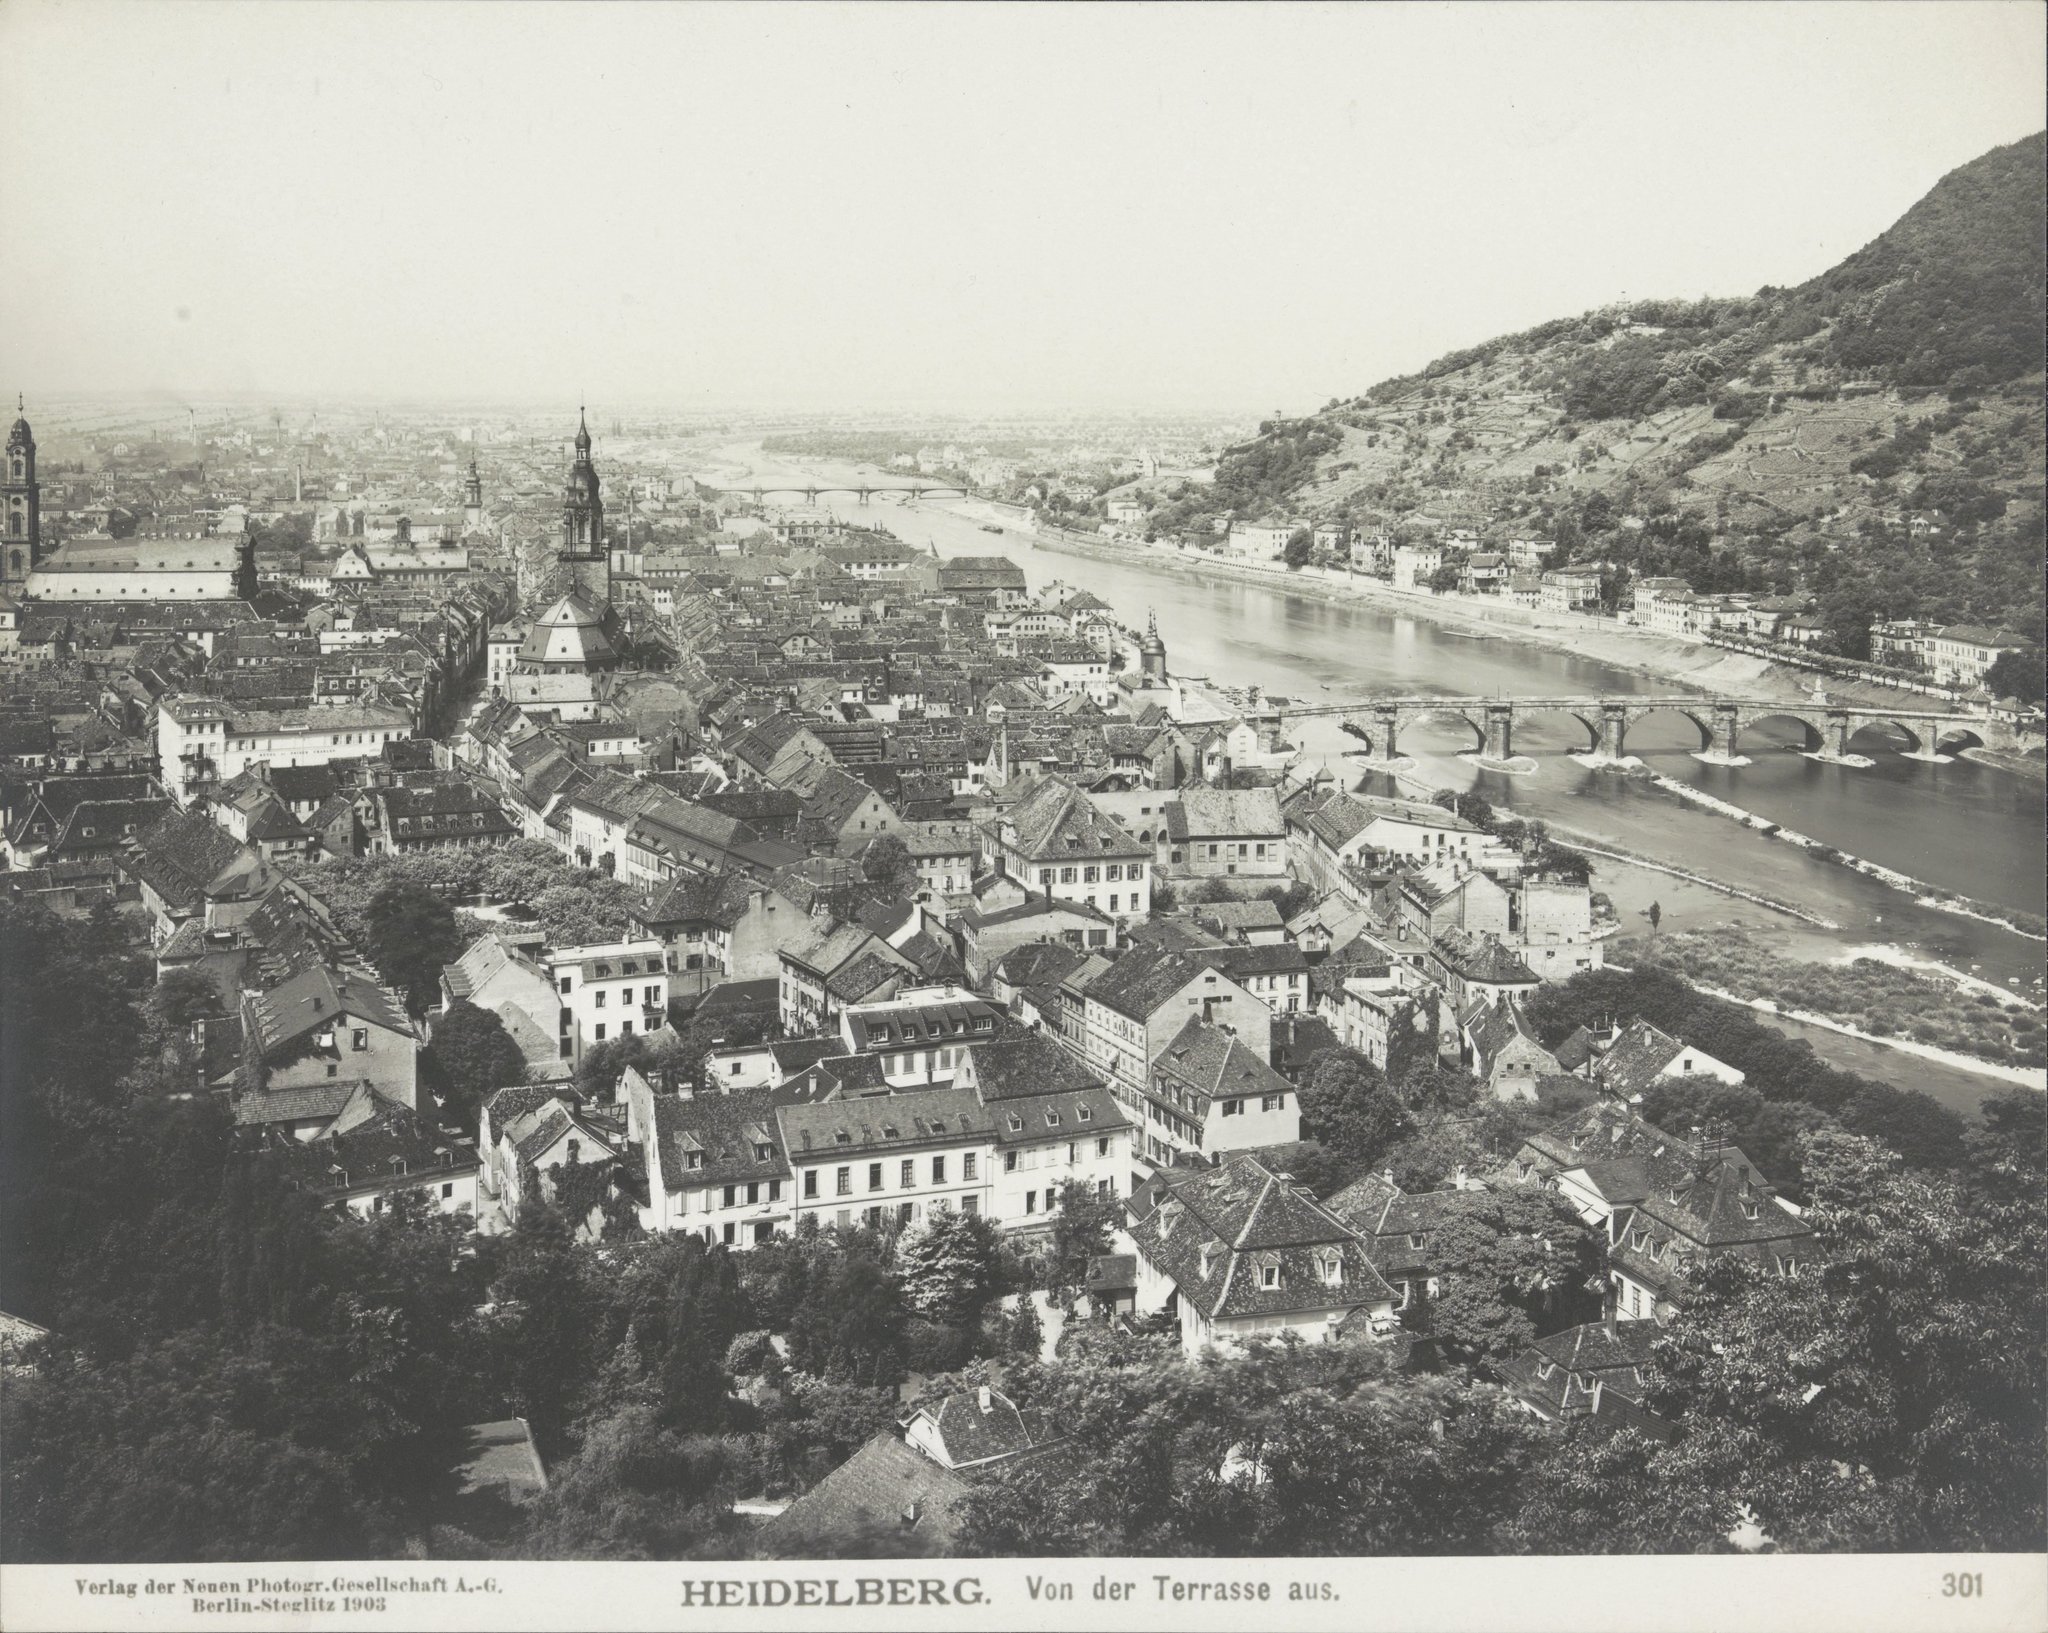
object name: photograph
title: Heidelberg. Von der Terrasse aus.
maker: Anonymous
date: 1903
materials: photographic support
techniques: gelatin silver print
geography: heidelberg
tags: landscape with bridge, viaduct or aqueduct, prospect of city, town panorama, silhouette of city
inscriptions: number: ‘301’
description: Onderdeel van Fotoalbum met opnames van Heidelberg en Schloss Heidelberg.